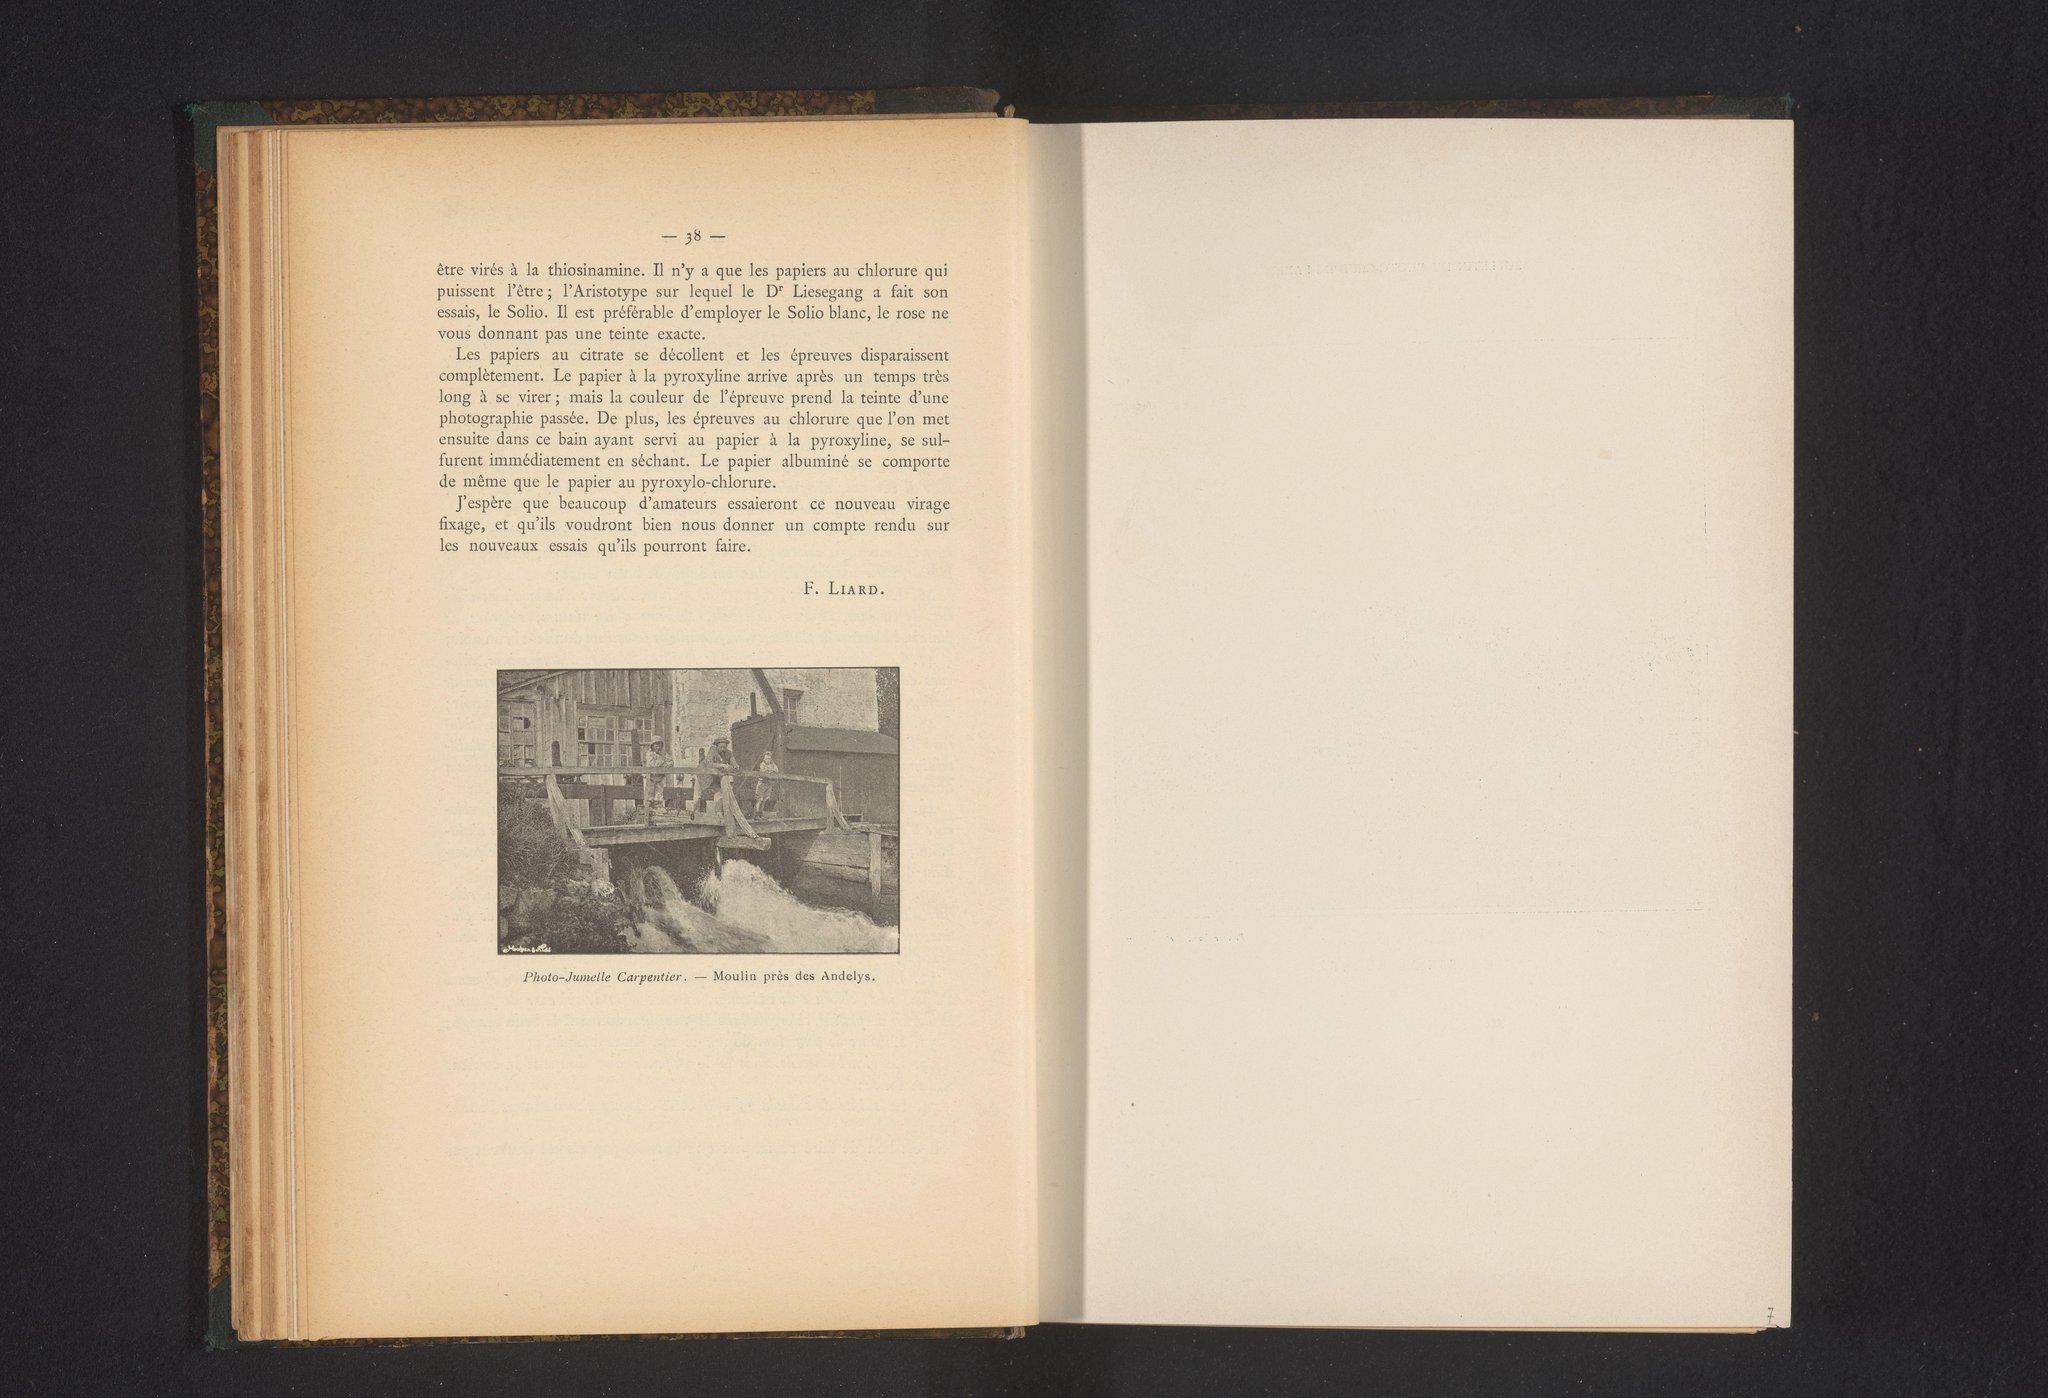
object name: page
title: Man en twee jongens op het gemaal van een molen bij Les Andalys, Frankrijk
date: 1890-1895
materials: paper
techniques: autotype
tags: watermill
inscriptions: name: ‘Mor[j]an & Kidd’